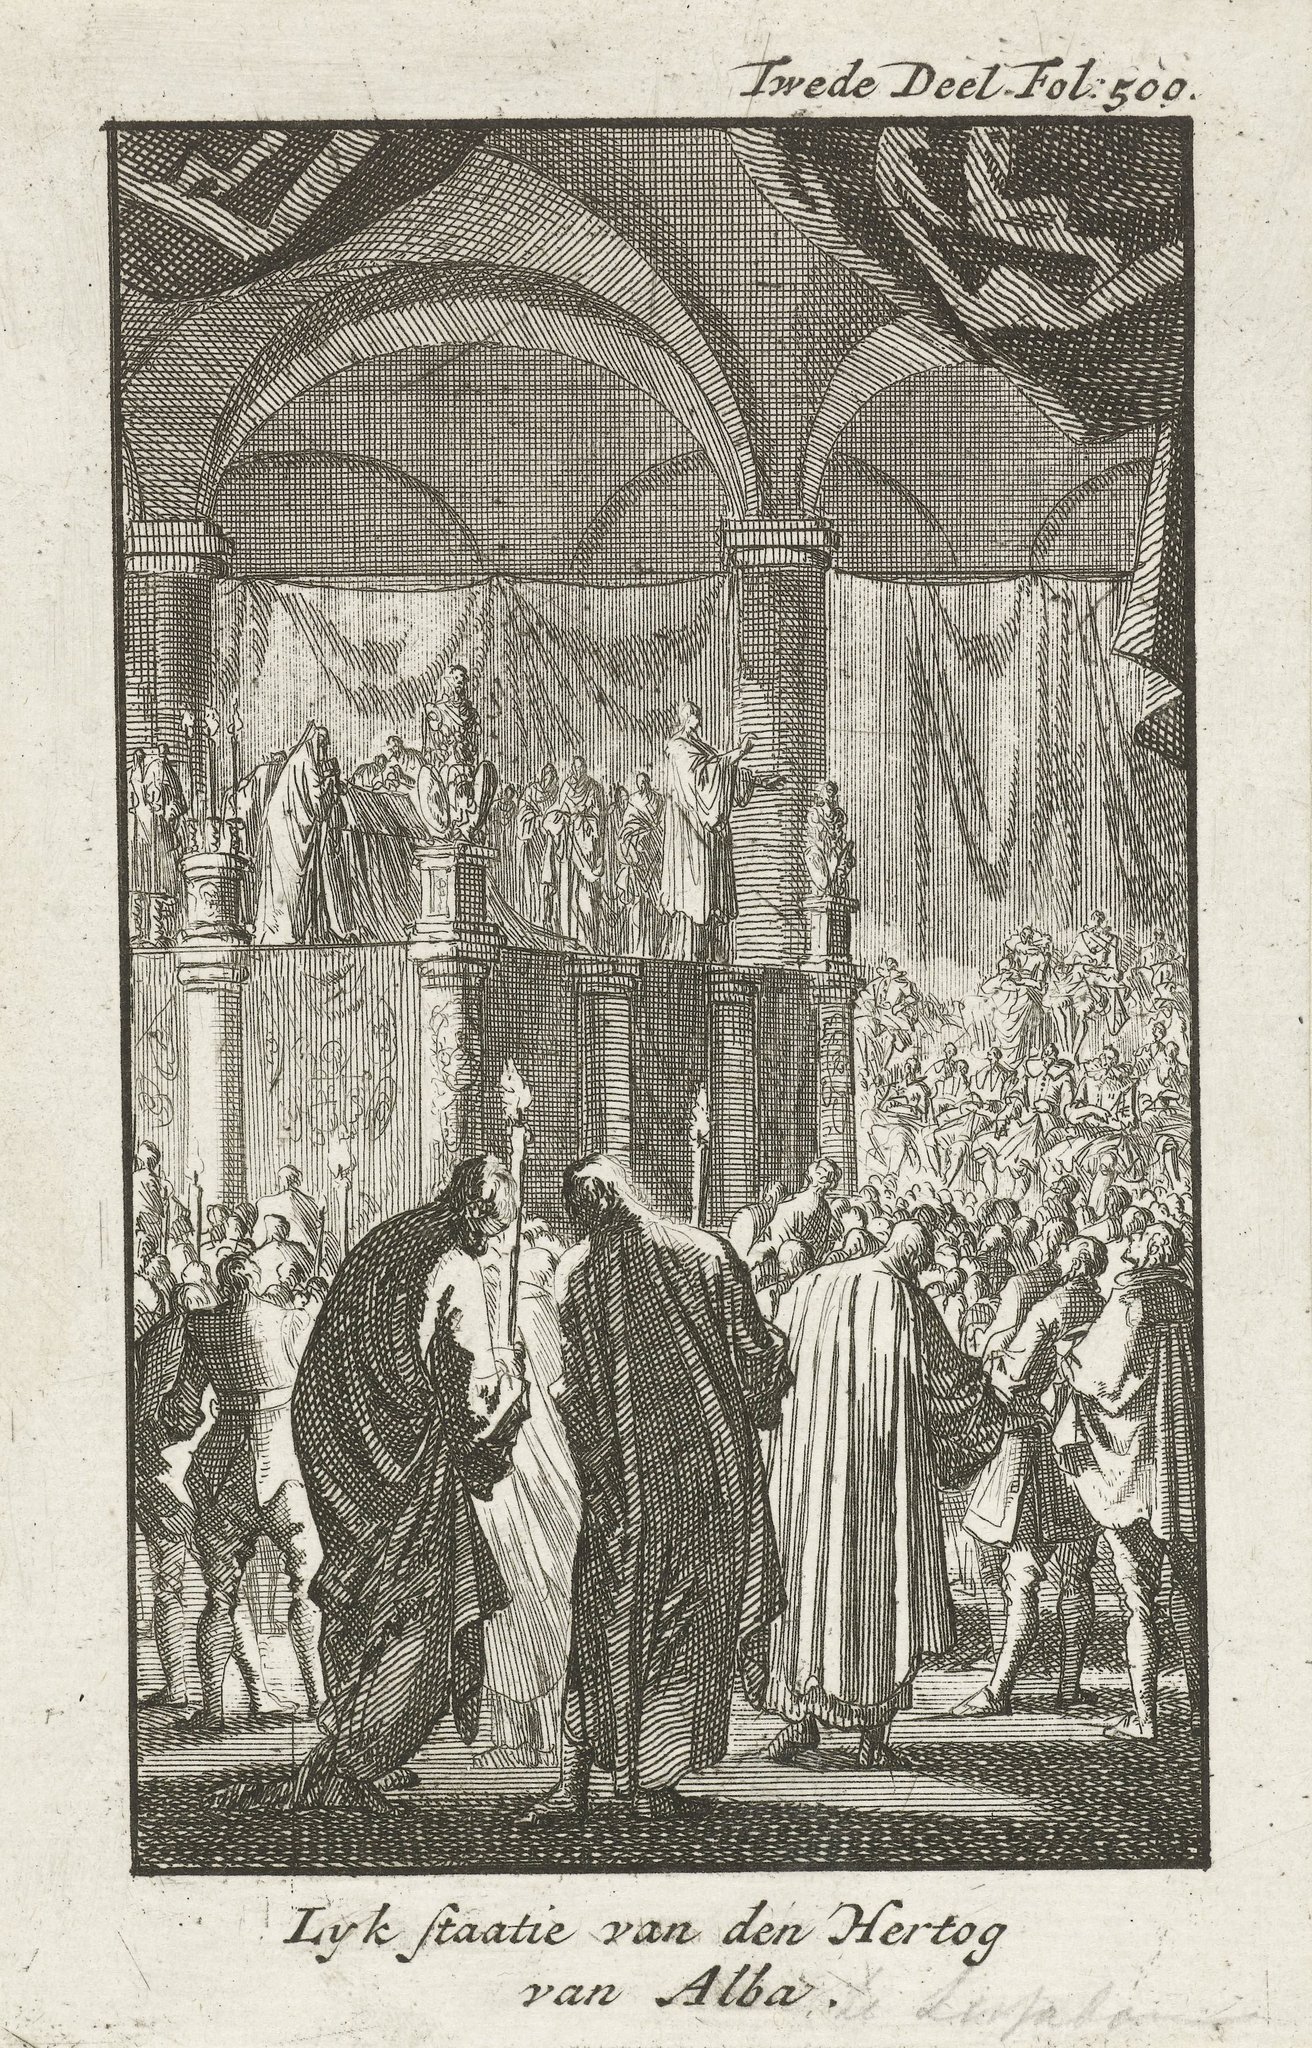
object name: print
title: Lijkstatie van de hertog van Alva, 1582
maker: jan luyken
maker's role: draughtsman, print maker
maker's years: 1649-1712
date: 1697-1699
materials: paper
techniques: etching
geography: northern netherlands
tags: fernando álvarez de toledo (3rd duke of alba), funerary ceremonial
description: In deze staat gebruikt als illustratie in: Marquis van Astorga, Het leven van Ferdinand Alvarez de Toledo, hertog van Alba, M. Uytwerf en E. Boucquet, 's-Gravenhage 1701, dl. II, fol. 500. Eerst gebruikt in G. Leti, Het Leven van Filips de II, 1699.